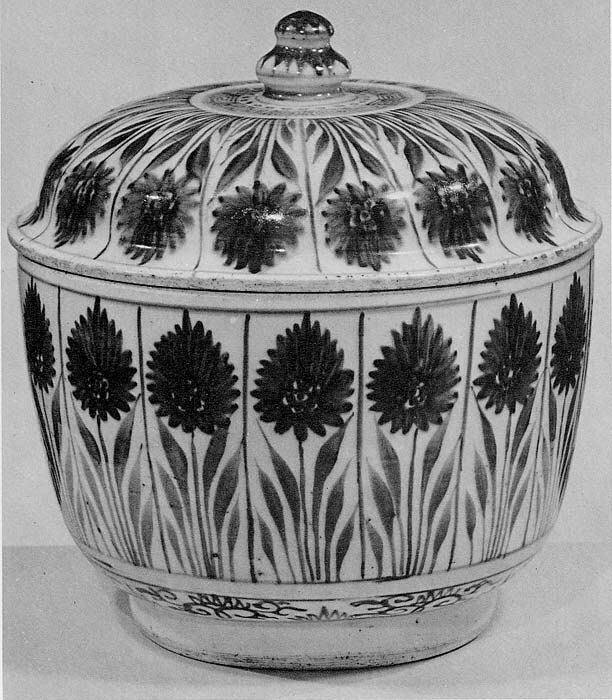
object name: covered bowl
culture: chinese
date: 1651-1675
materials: porcelain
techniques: painting, underglaze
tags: flowers,leaves